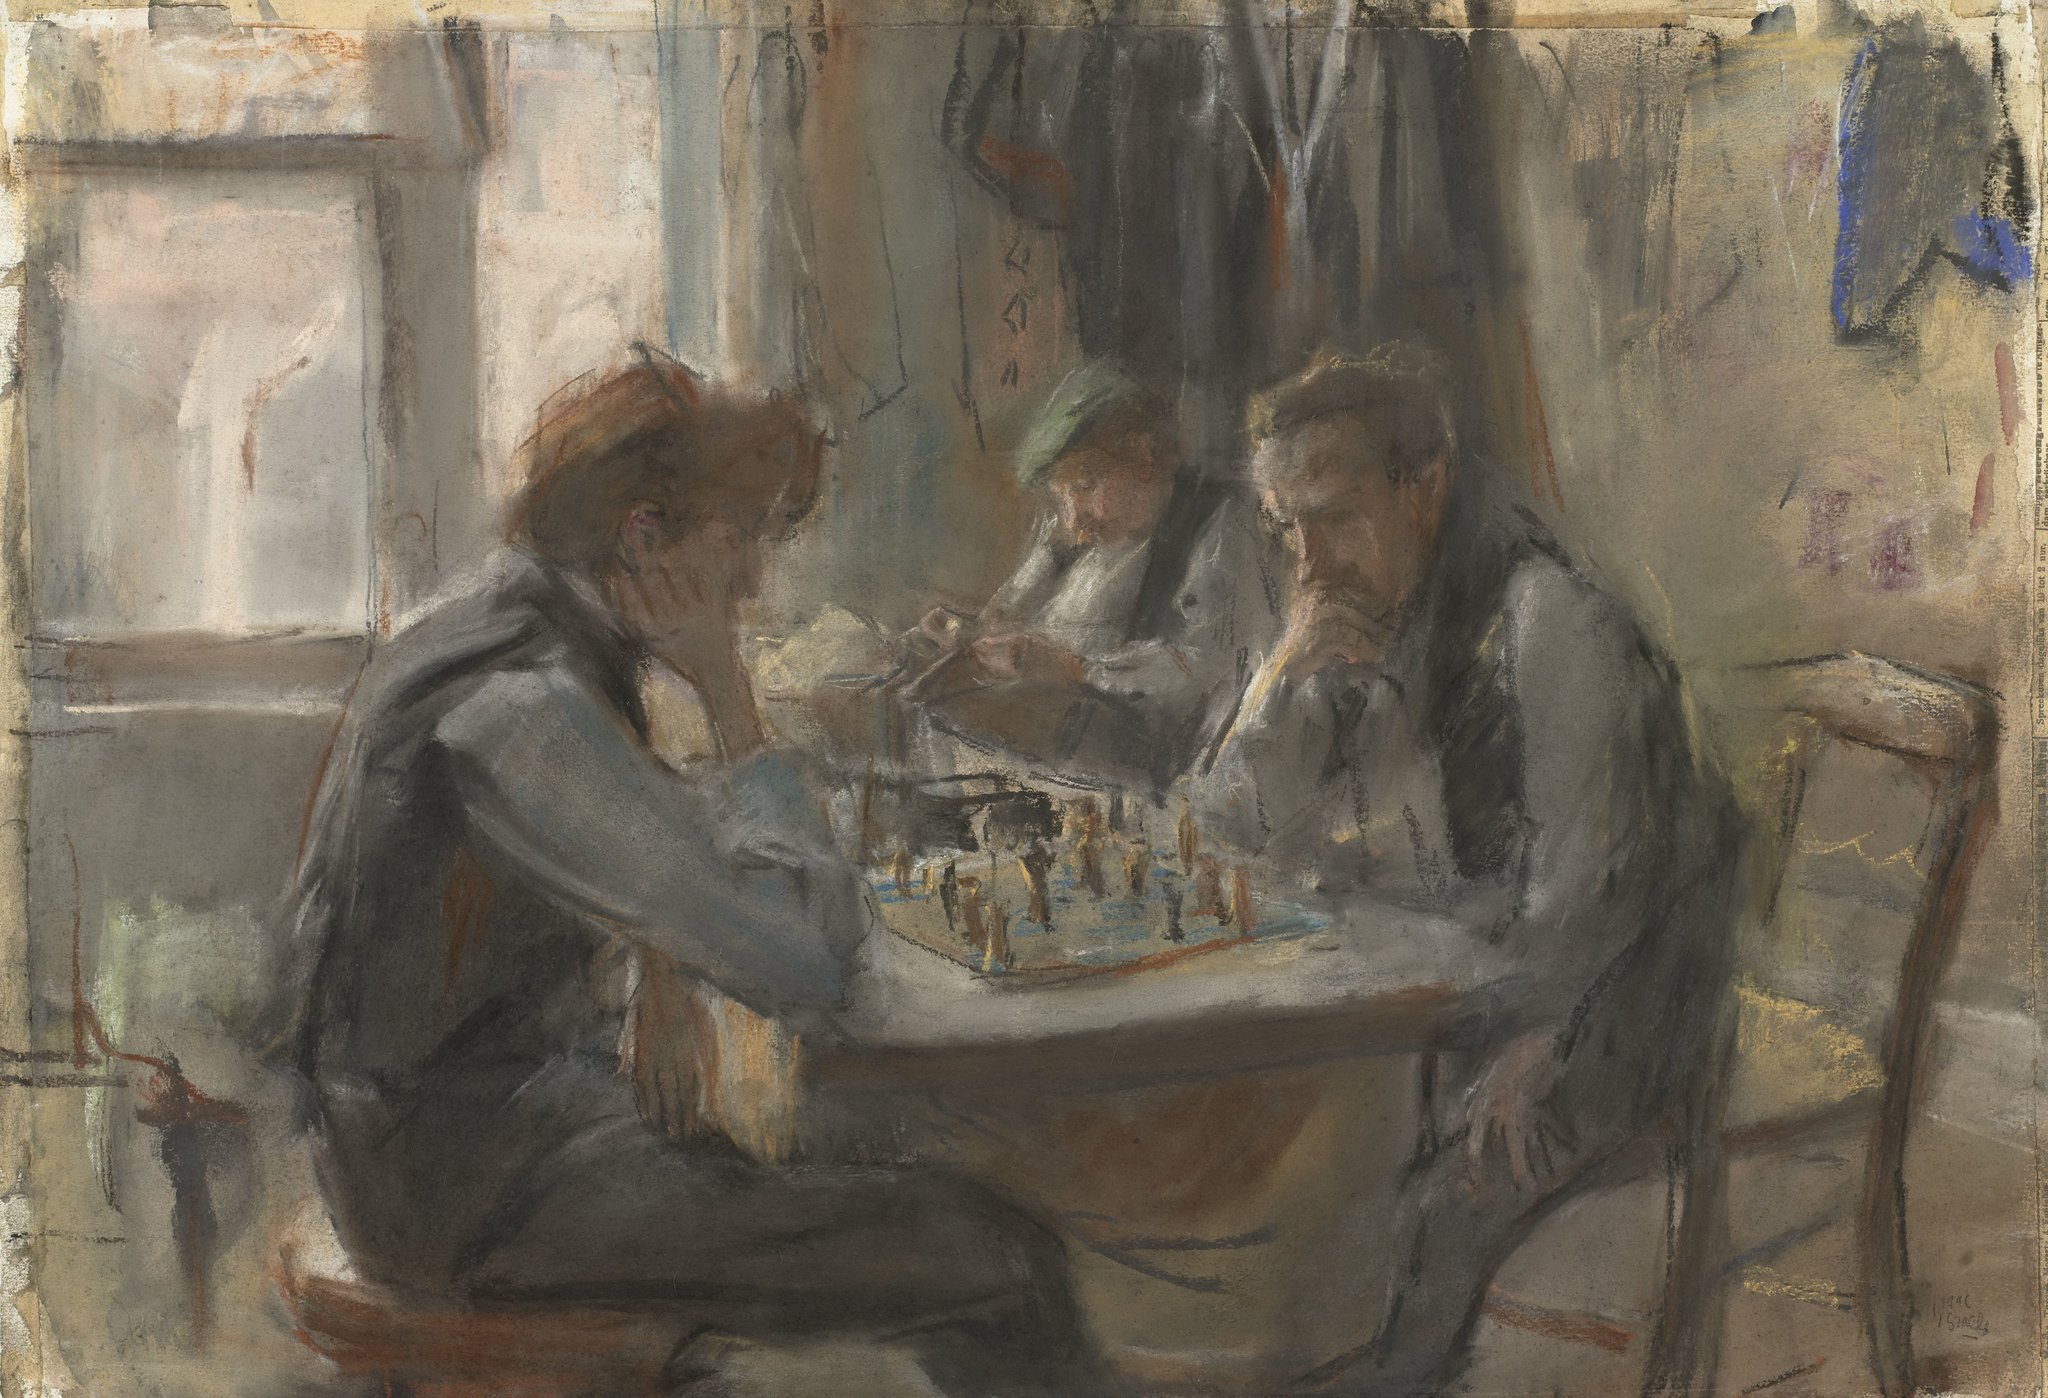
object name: drawing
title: De schaakspelers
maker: isaac israels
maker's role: draughtsman, painter, print maker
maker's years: 1865-1934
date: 1875-1922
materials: paper, pastel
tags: chess (+ sportsman, player, etc.)